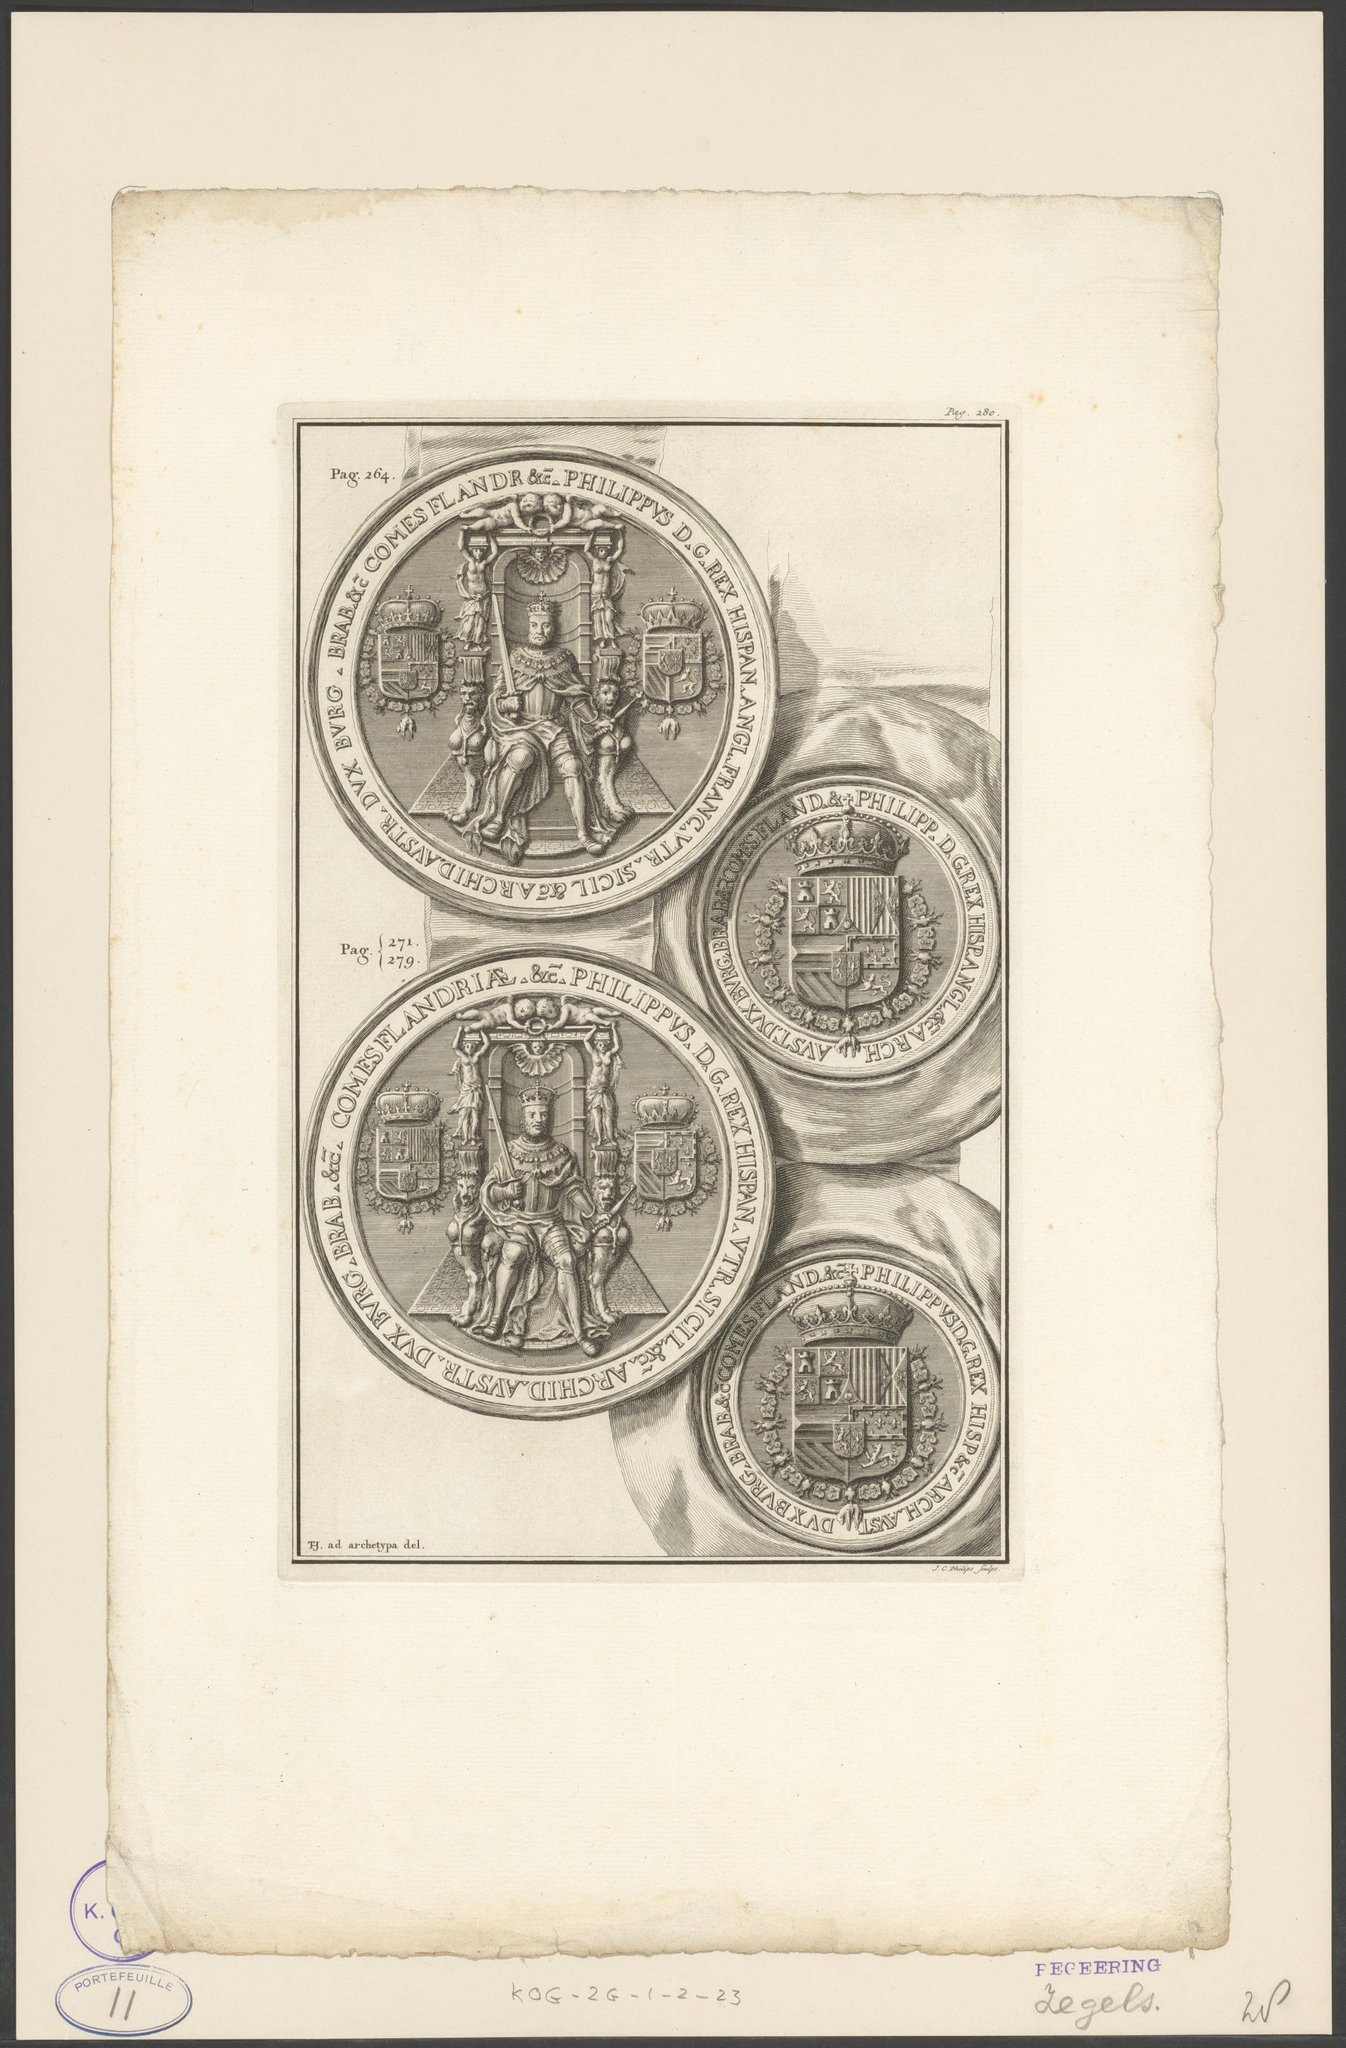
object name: print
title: Blad met zegels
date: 1751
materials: paper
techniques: engraving, etching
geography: netherlands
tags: seal, stamp, seal (as symbol of the state, etc.)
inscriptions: collector's mark, collector's mark: Lugt 1641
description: Diverse zegels, Pag. 280. Met verwijzingen naar andere nummers en paginanummers. Onderwerpsrubrieken binnen de Atlas Zeden en Gewoonten: Regeering, Zegels.